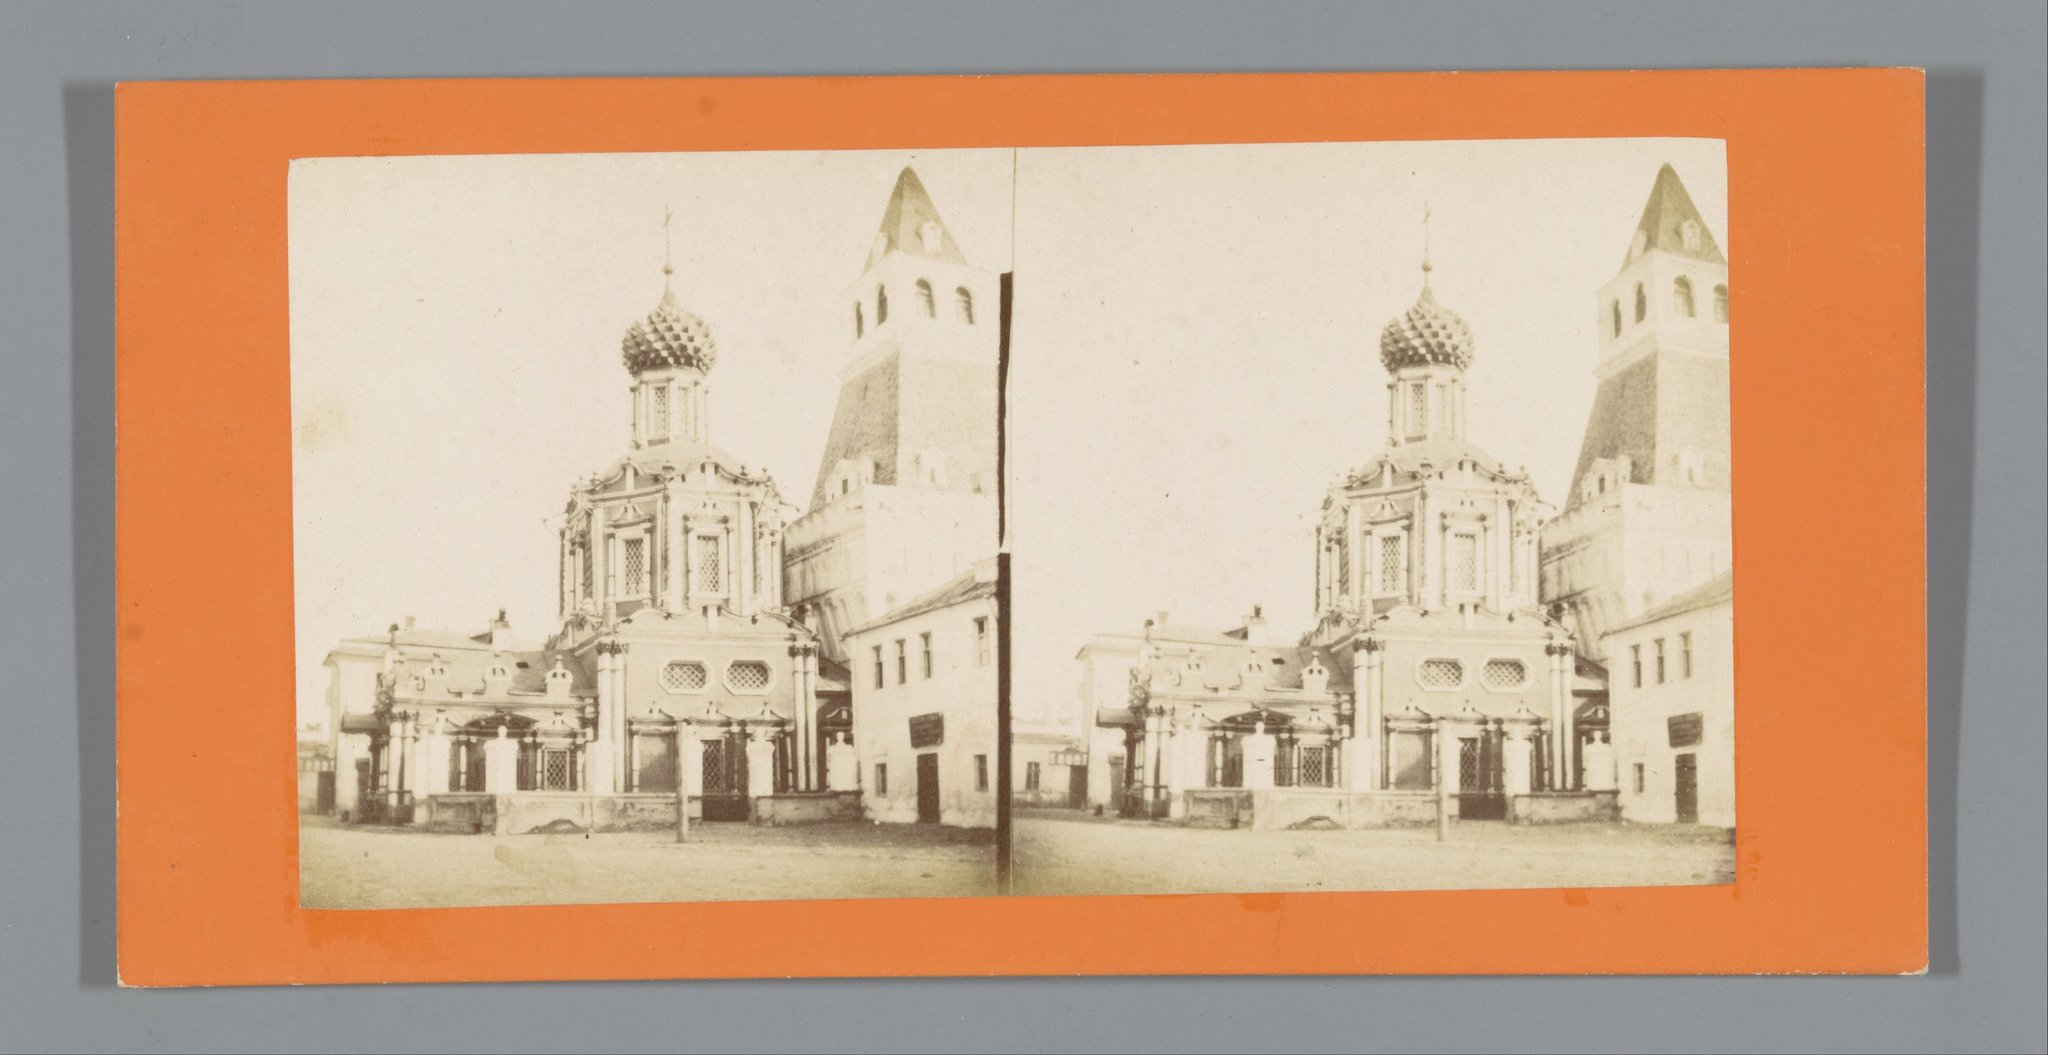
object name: stereograph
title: Gezicht op een kerk, vermoedelijk in Moskou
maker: Anonymous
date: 1850-1880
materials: cardboard, photographic support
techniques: albumen print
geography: moscow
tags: church (exterior)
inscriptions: inscription: ‘93 Monastere grec St Nicolas Moscou’